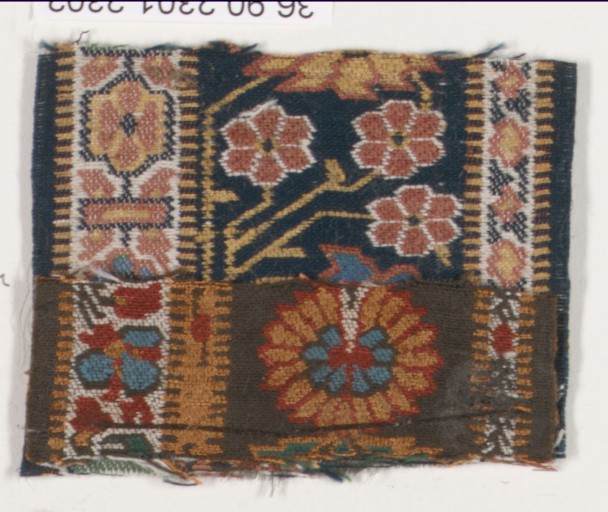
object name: border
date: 1801-1900